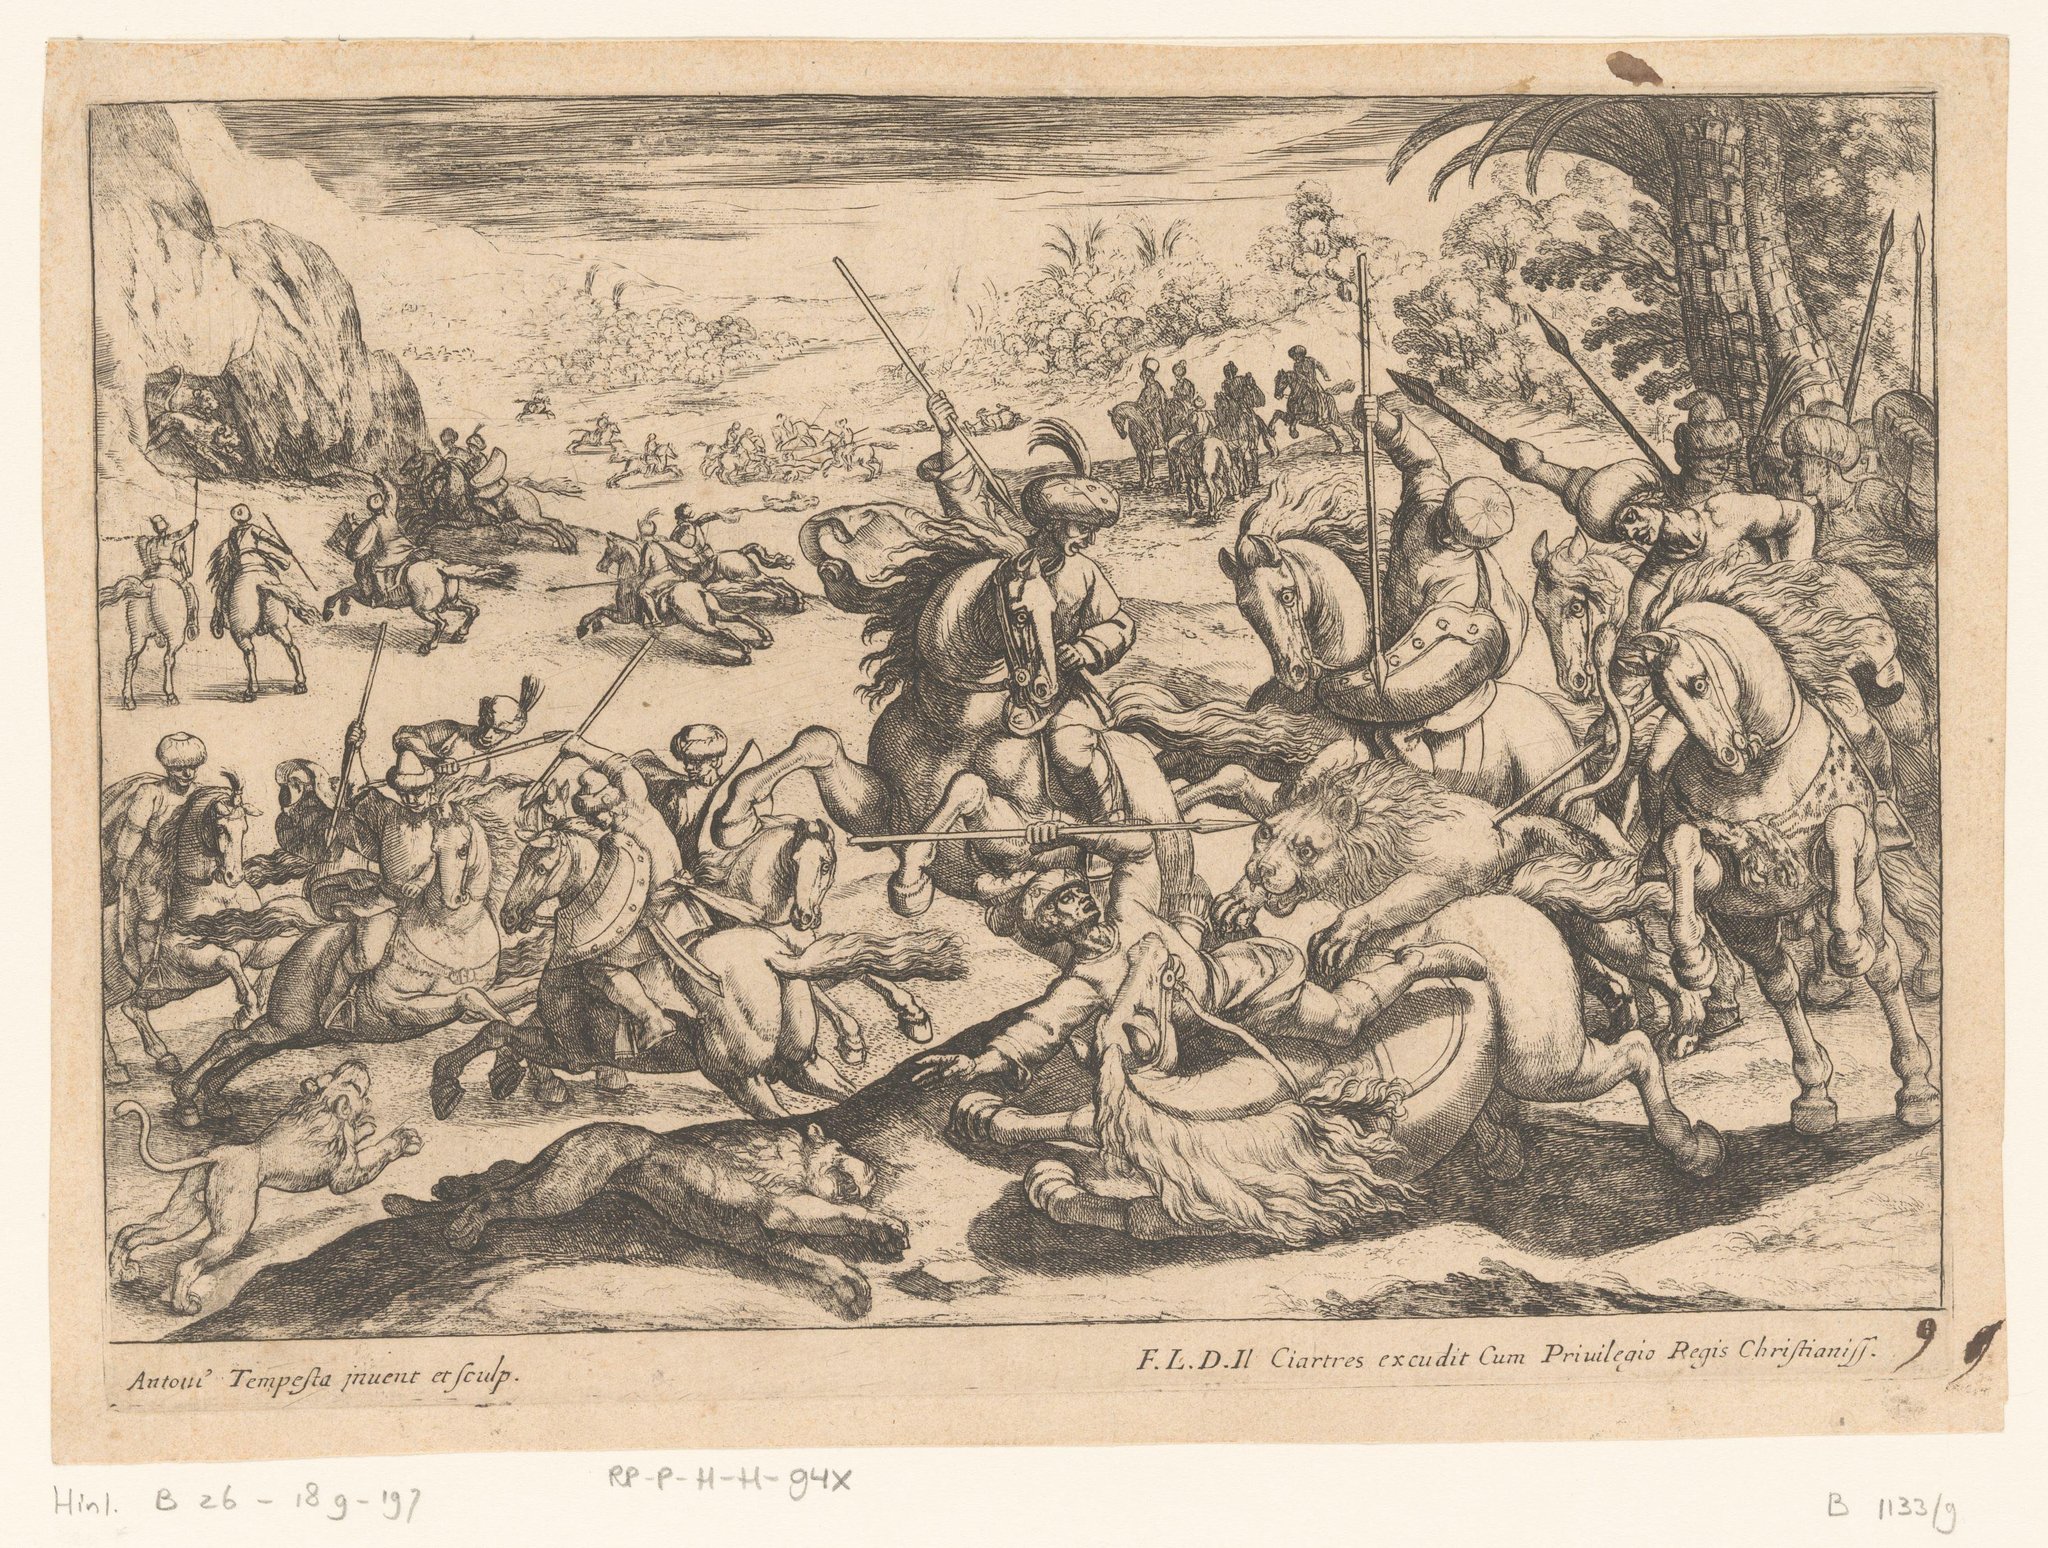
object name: print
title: Jacht op leeuwen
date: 1600-1620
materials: paper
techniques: etching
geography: italy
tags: hunter fighting a lion, lion hunt, hunter, hunters hunting (n.b.: in 1988-1990 this notation denoted the concept of 43c11421 'hunters resting during the hunt')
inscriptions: collector's mark: Lugt 11, collector's mark: ‘Hinloopen’, number: ‘9’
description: Deze prent maakt deel uit van een reeks van zeven prenten met jachtscènes. Op verso is het hoofd van een paard overgetrokken in rood potlood.